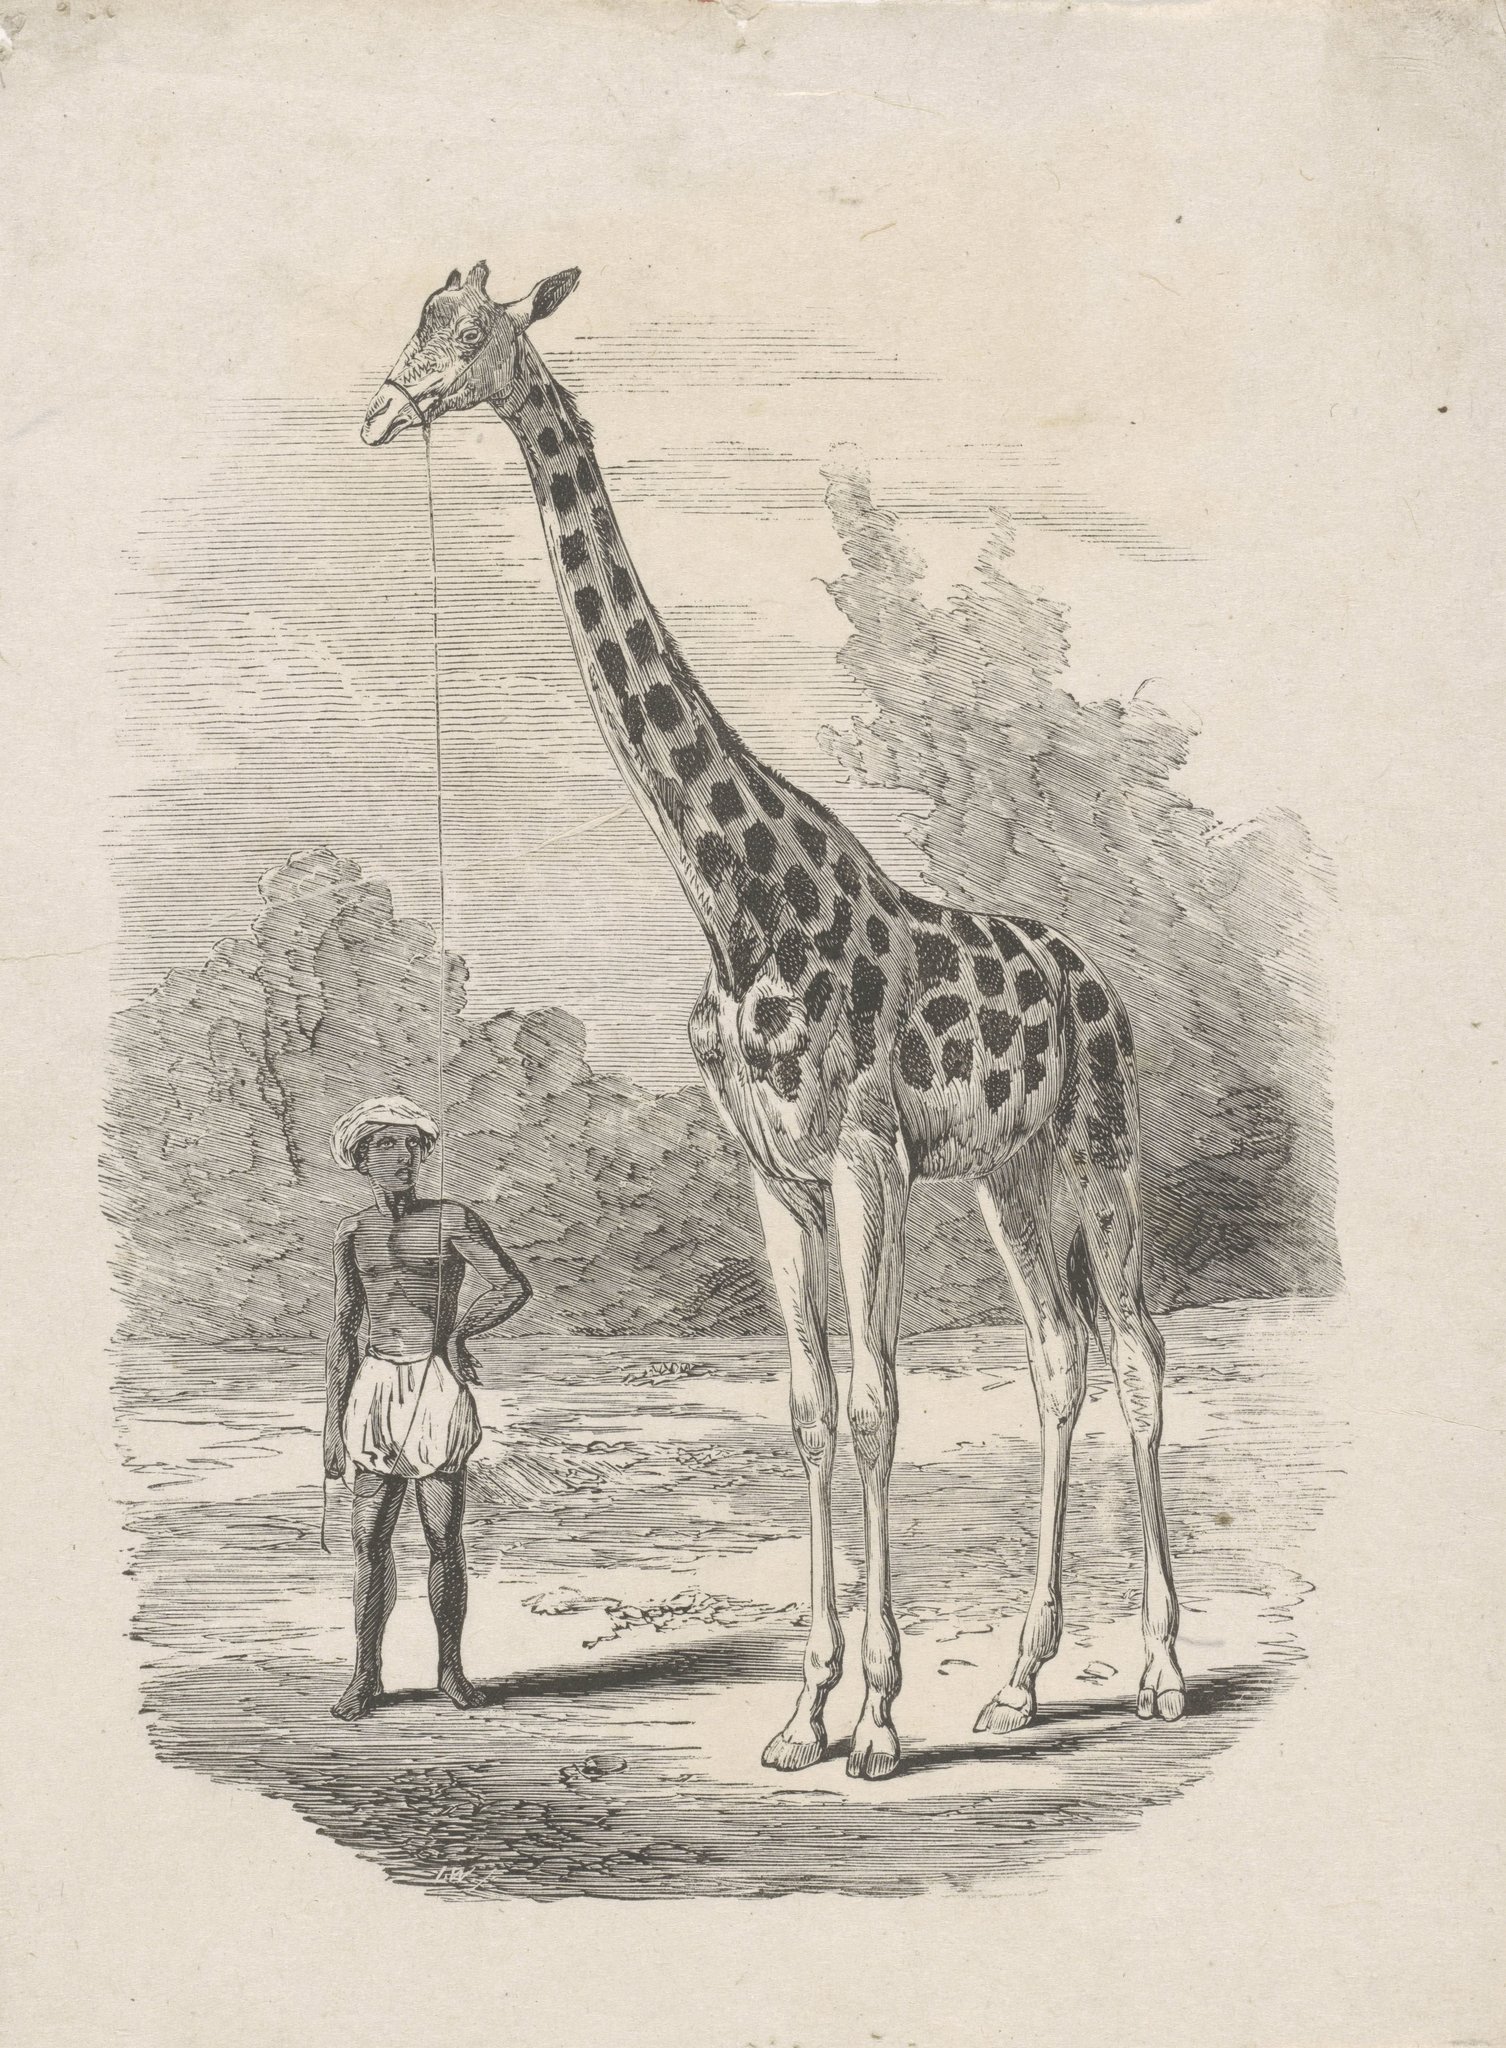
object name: print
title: Donkere man met een tulband en een pofbroek een giraf aan een touw vasthoudend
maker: isaac weissenbruch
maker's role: print maker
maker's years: 1826-1912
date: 1836-1912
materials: paper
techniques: engraving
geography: netherlands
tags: head-gear: turban, human races, peoples and nationalities (other than prehistoric or extinct), hoofed animals: giraffe